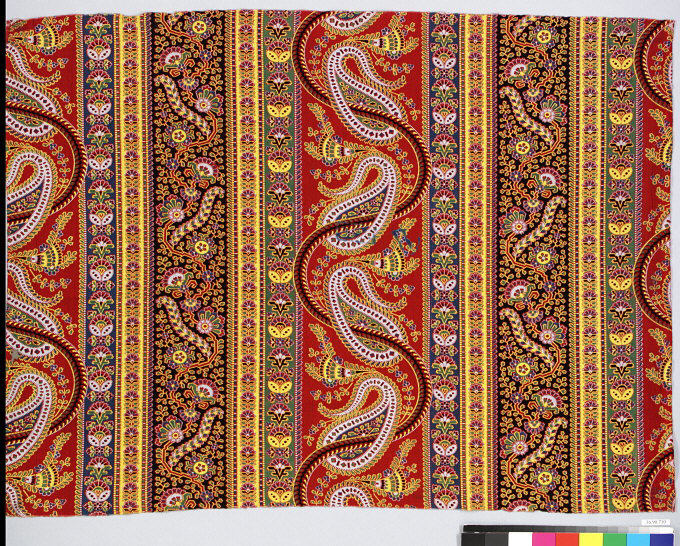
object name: piece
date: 1867-1900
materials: cotton